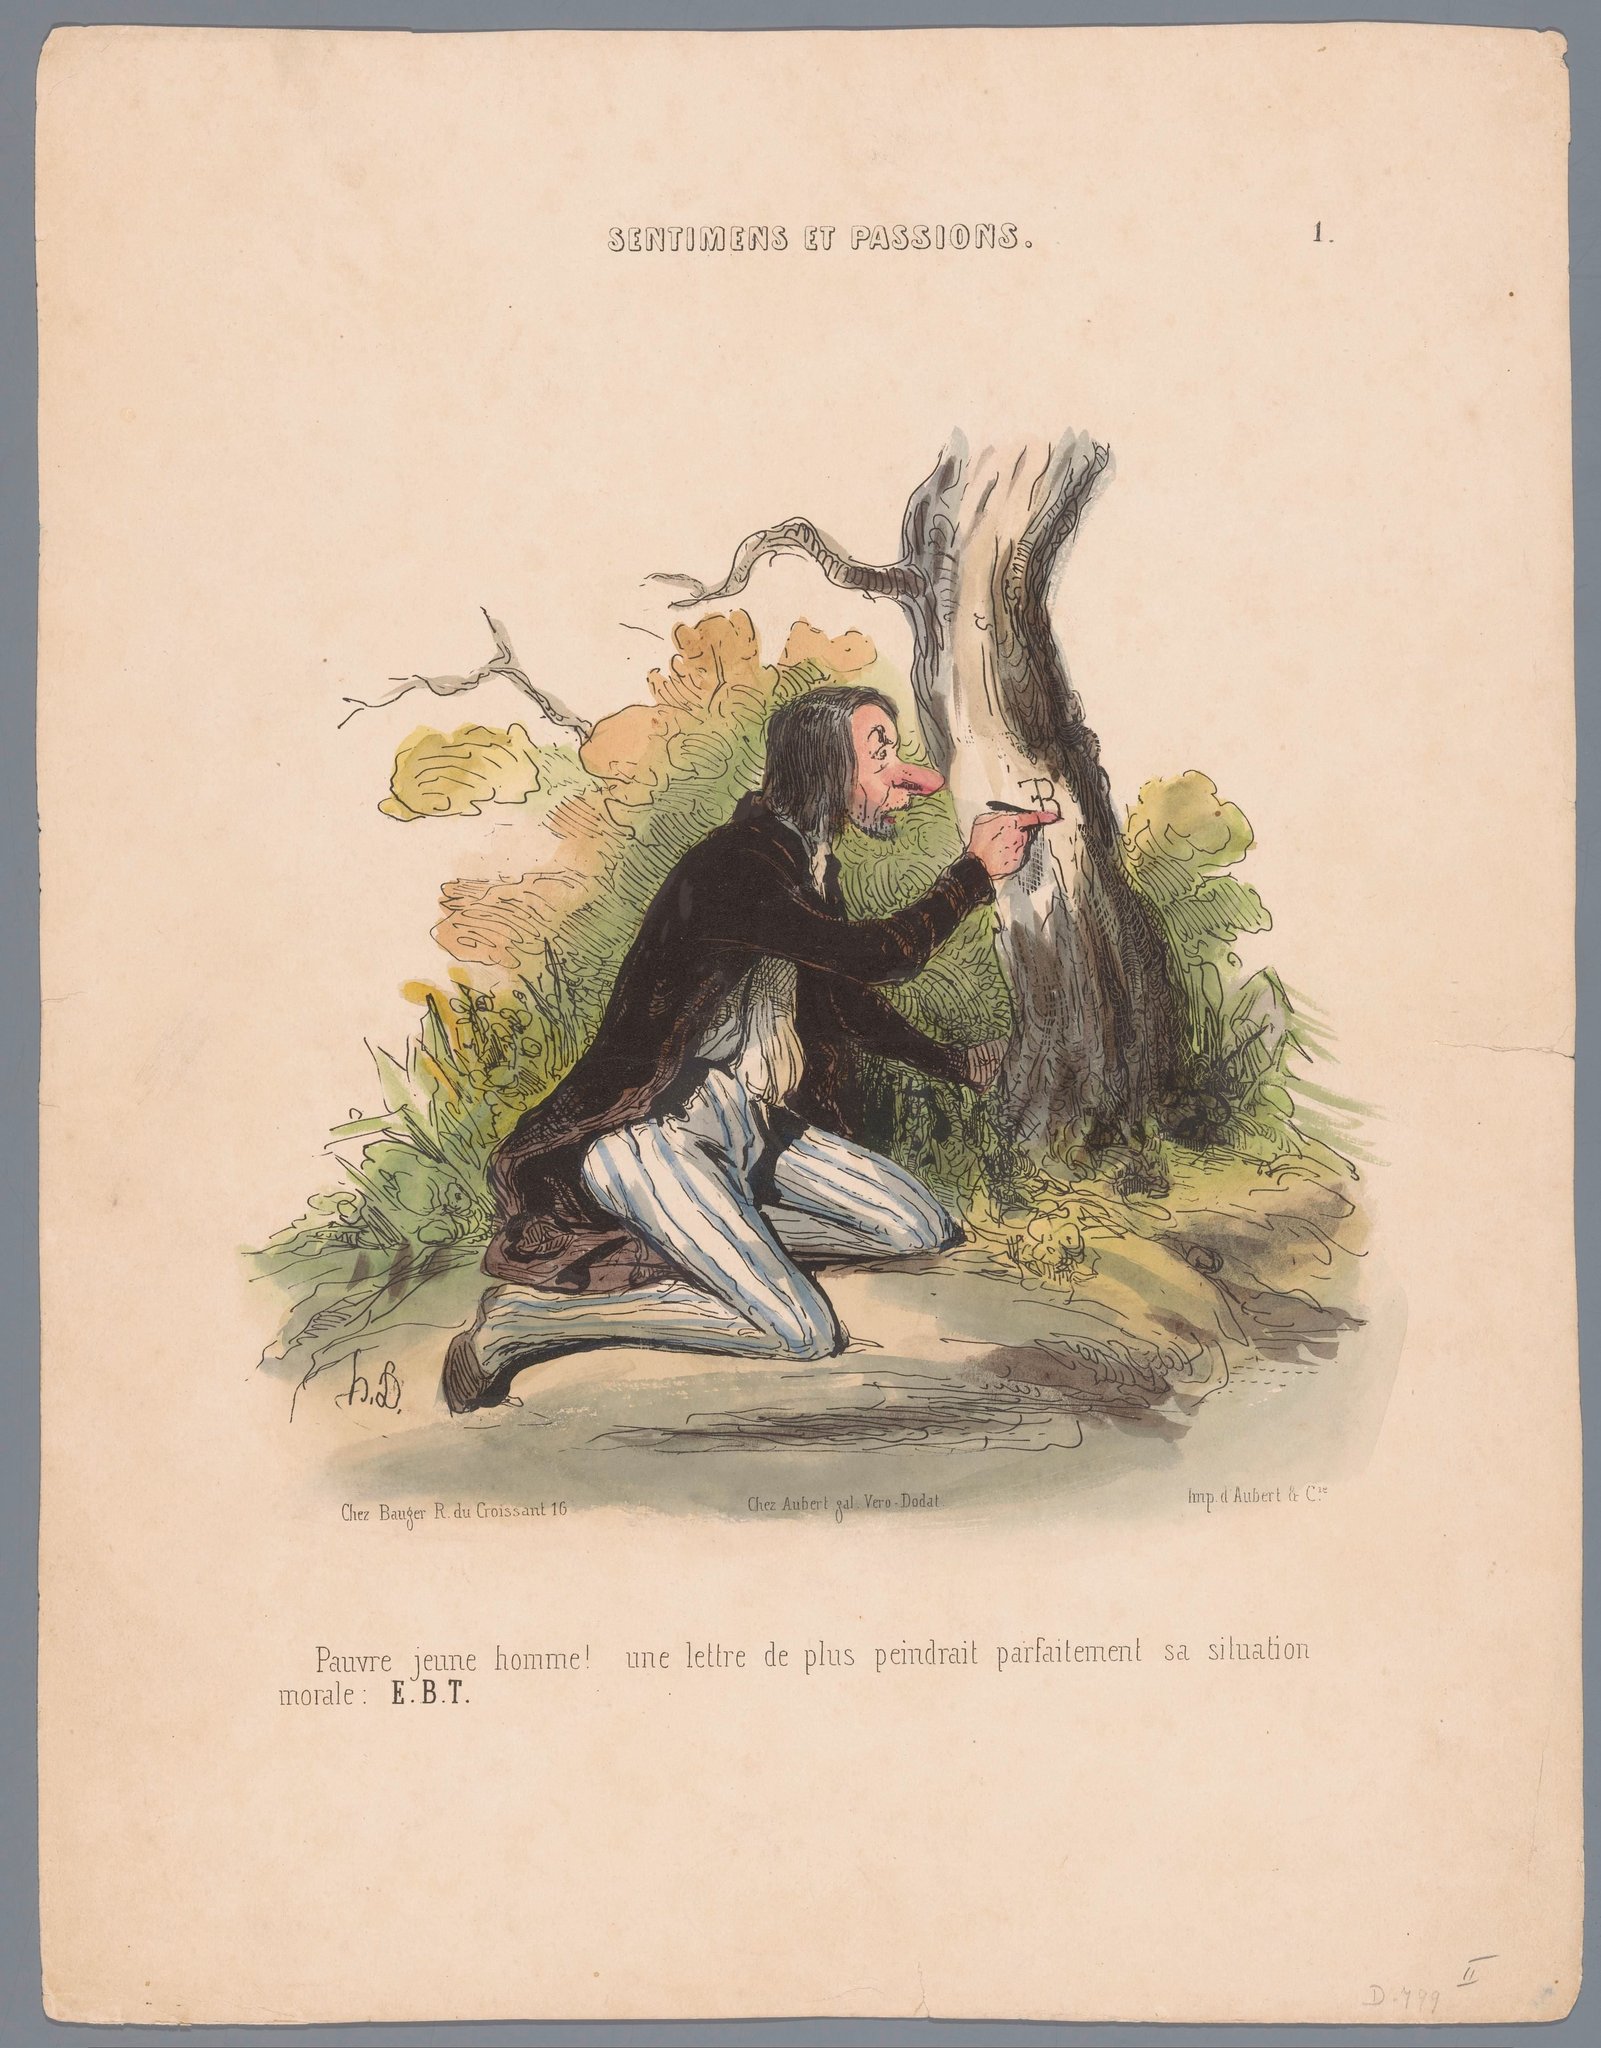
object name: cartoon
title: Hartstochten en gevoelens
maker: honoré daumier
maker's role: draughtsman, painter, print maker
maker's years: 1808-1879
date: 1840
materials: paper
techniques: hand coloring, lithograph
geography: paris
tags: caricatures (human types), carving heart and initials in an object, e.g. a tree trunk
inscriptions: collector's mark: Lugt 2233, collector's mark: Lugt 2228a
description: Prent mogelijk uit: Le Charivari, 5 juni 1840.